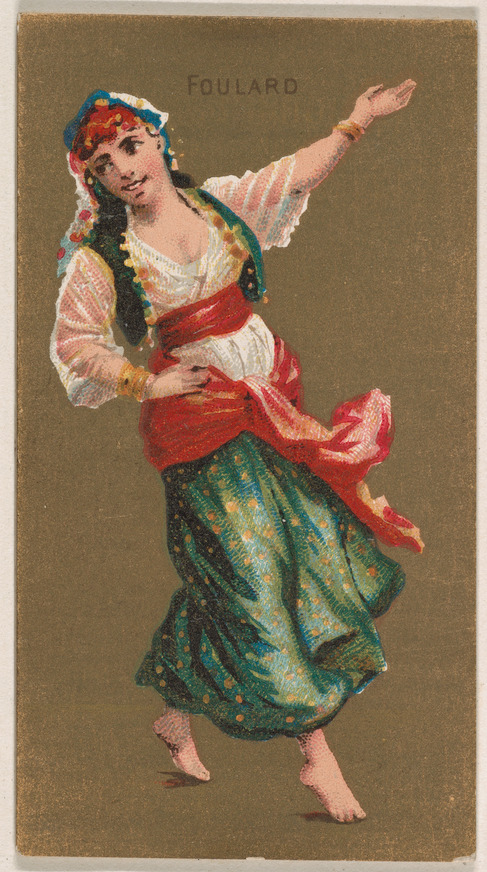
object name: print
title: Foulard, from National Dances (N225, Type 2) issued by Kinney Bros.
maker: kinney brothers tobacco company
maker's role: publisher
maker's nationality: american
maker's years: 1869-2011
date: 1889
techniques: color lithograph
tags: women,dancing,dancers